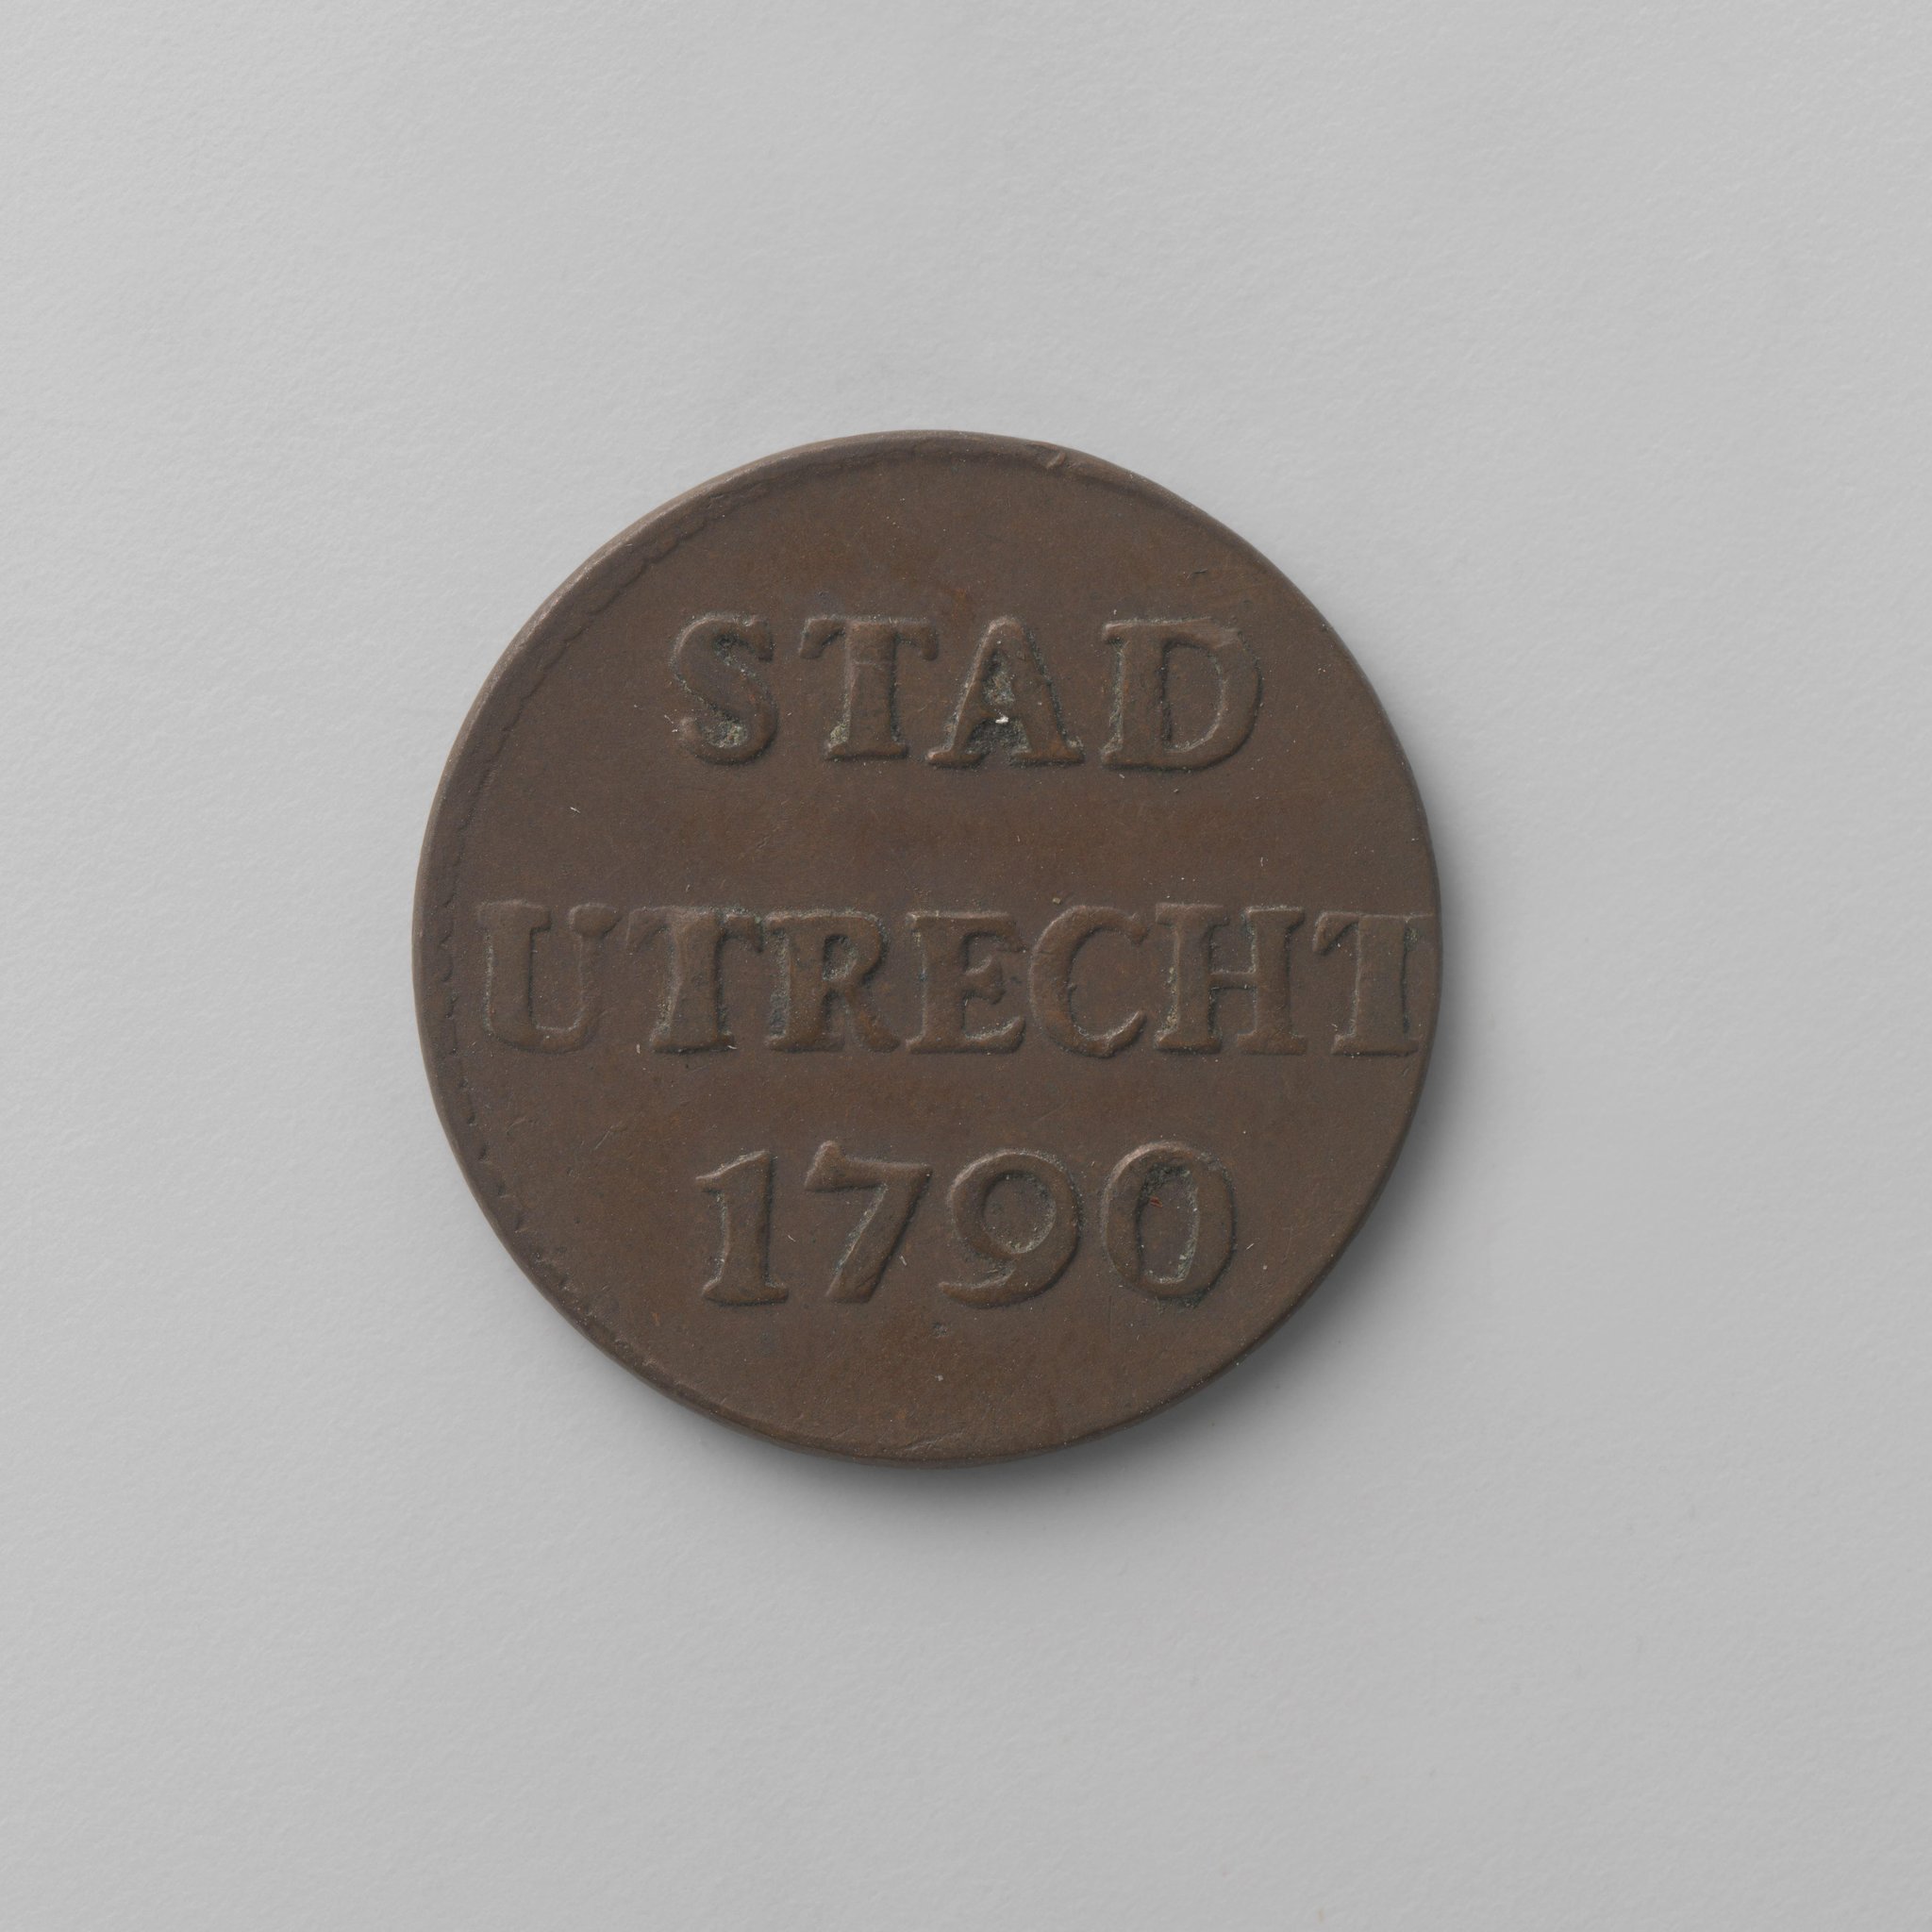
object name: coin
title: Duit van de stad Utrecht, 1790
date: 1790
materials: copper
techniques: striking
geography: utrecht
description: Koperen munt. Voorzijde: gekroond stedelijk wapenschild, gehouden door twee leeuwen met in afsnede dubbele lijn, waaronder een versierde accolade met een grote schelp. Keerzijde: opschrift in twee regels, waaronder jaartal. Jaartal met Arabische 1.